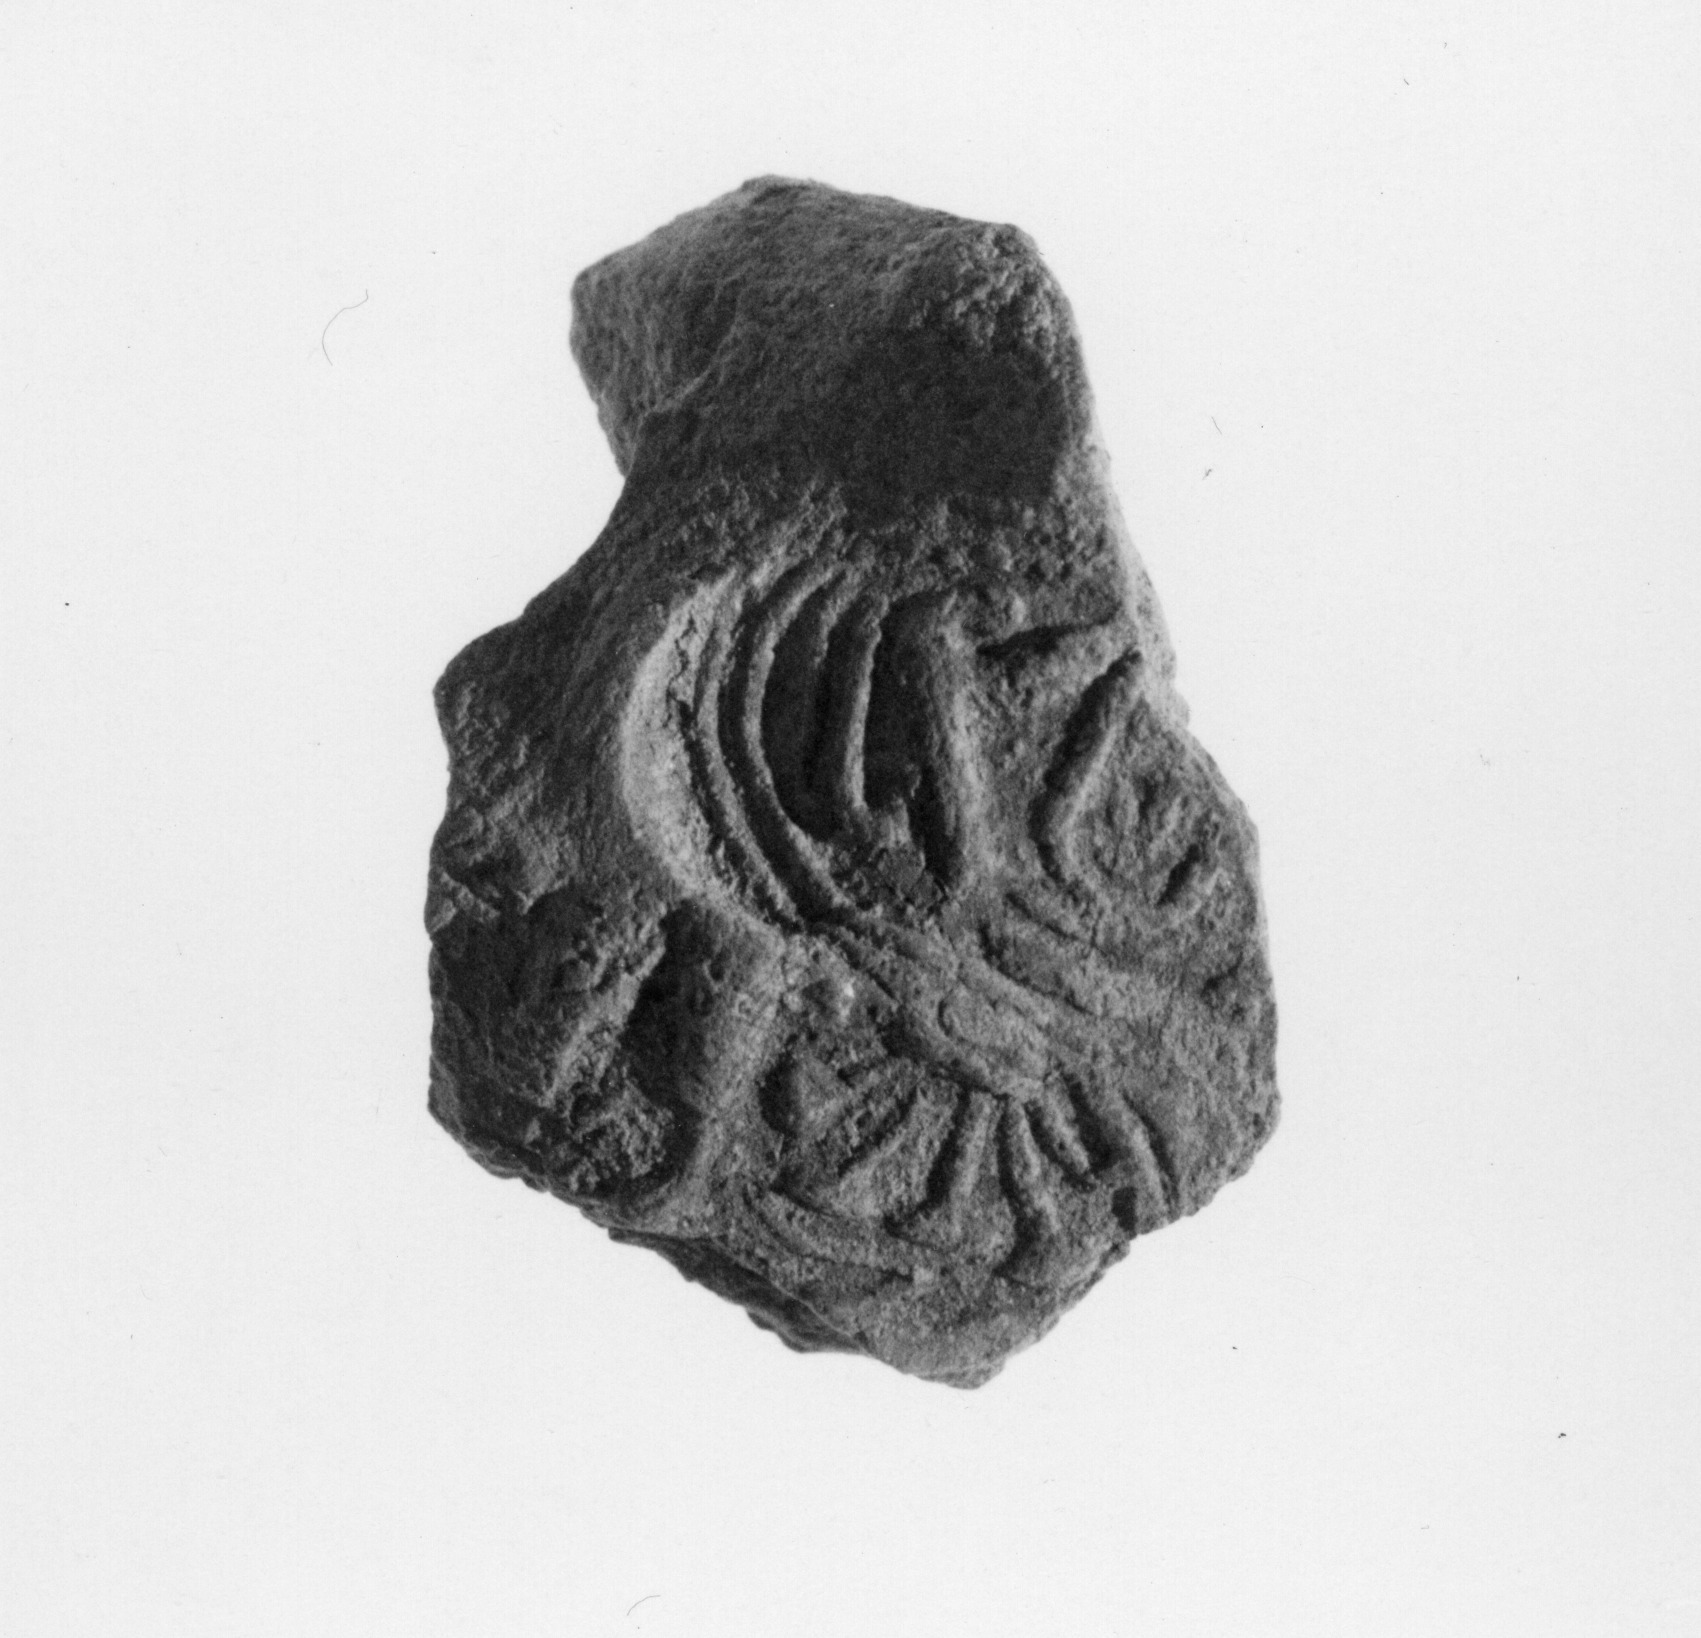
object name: sealing, amenhotep iii, nebmaatre, cobra,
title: Document Sealing With Multiple Seal Impressions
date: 1390-1352 BCE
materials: mud